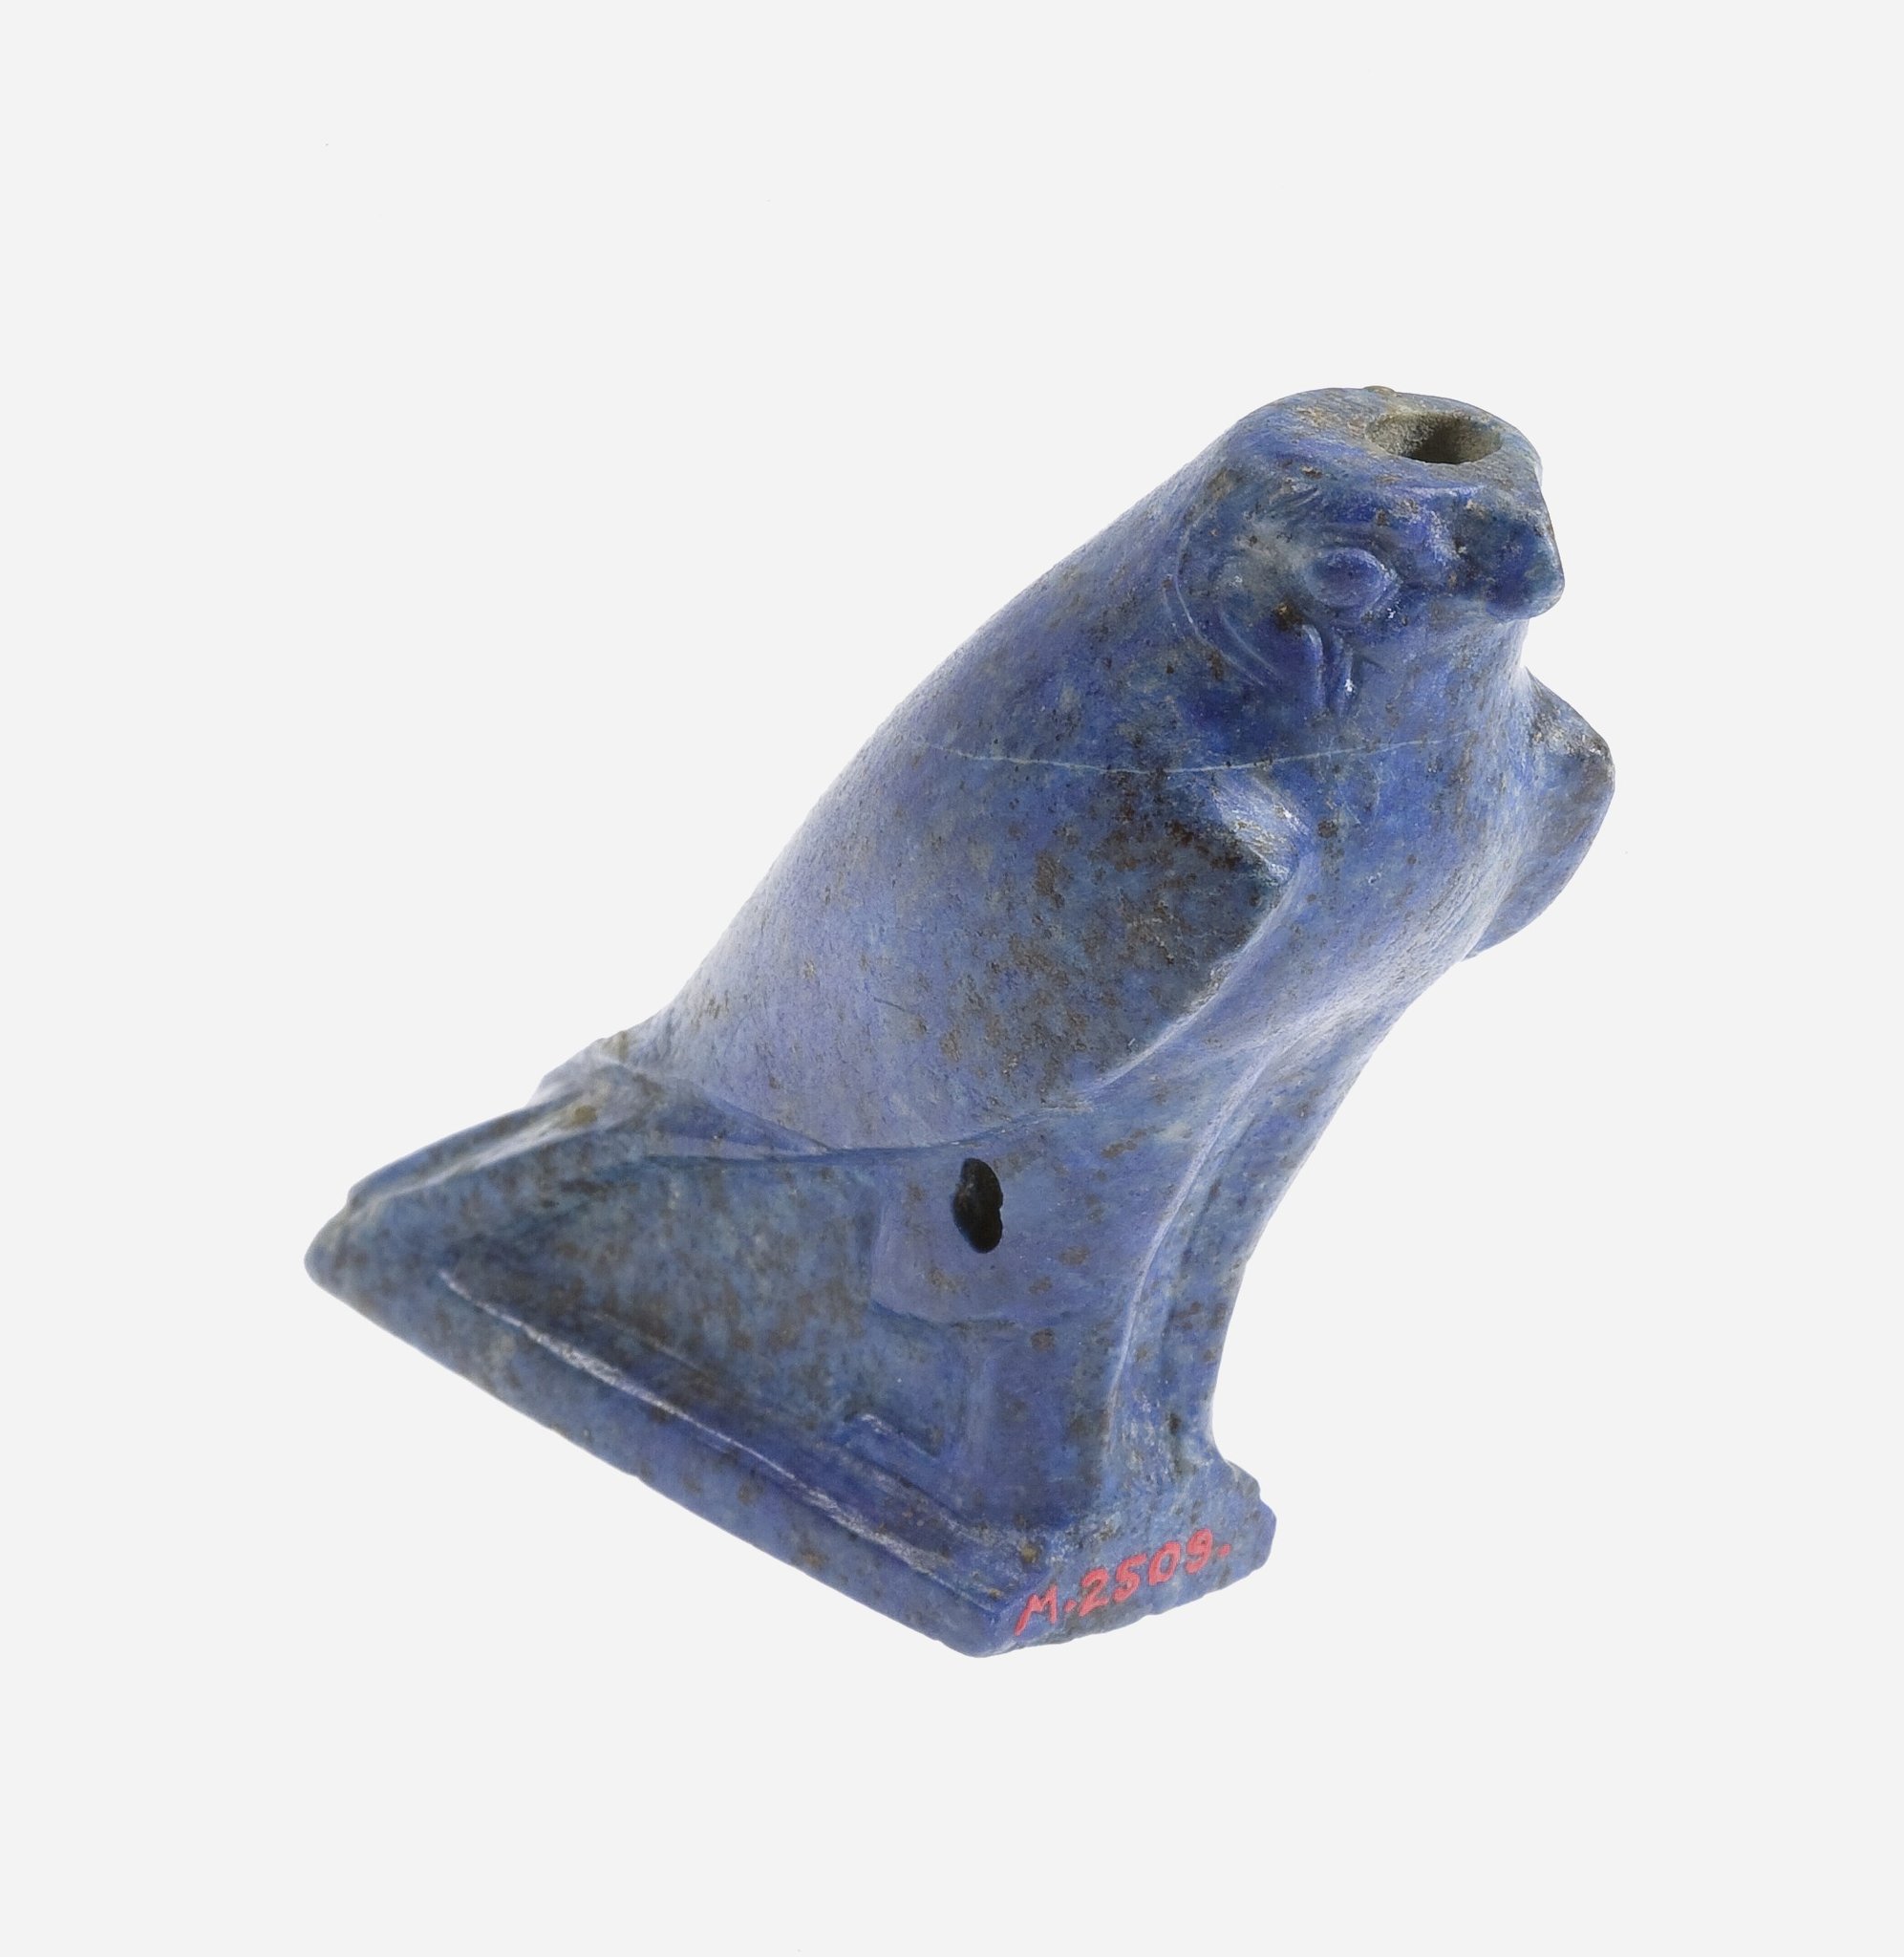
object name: amulet, falcon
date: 664-332 BCE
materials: lapis lazuli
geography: egypt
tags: falcons